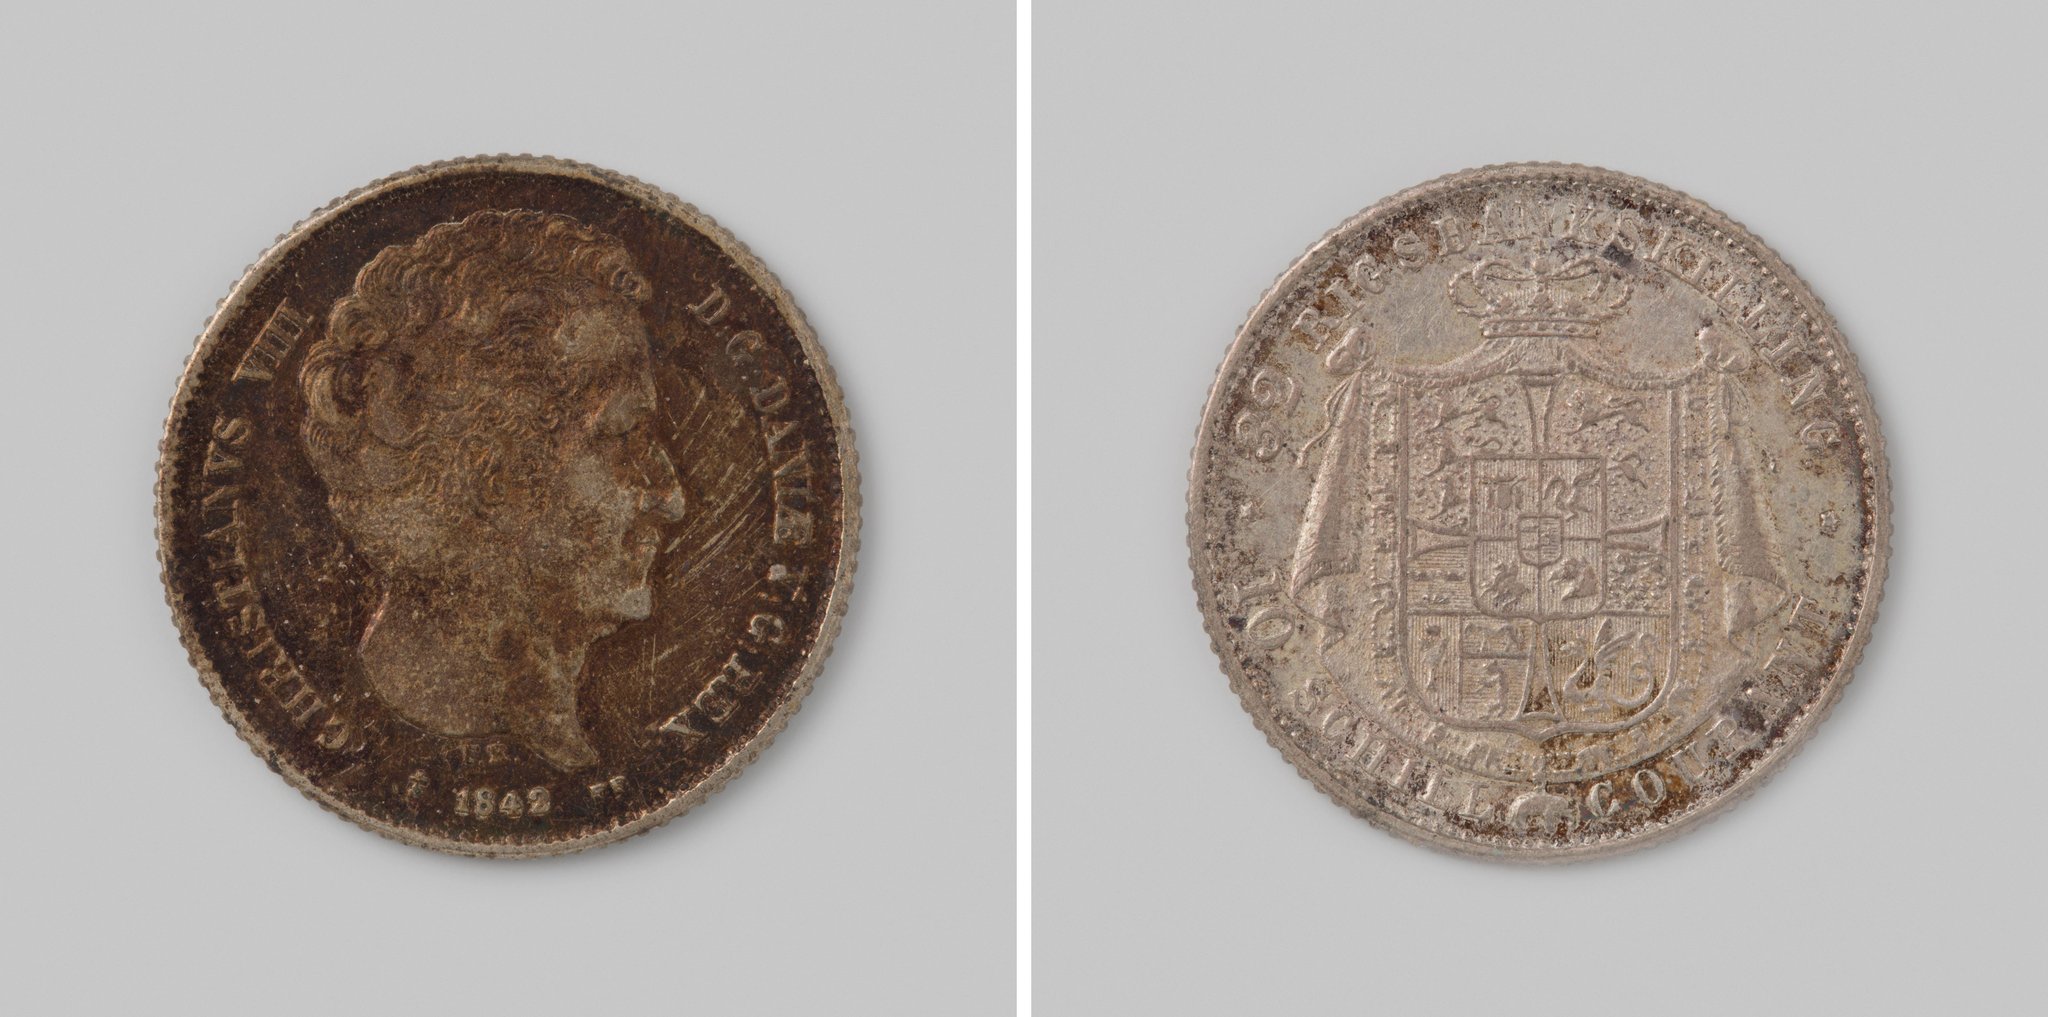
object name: coin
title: 32 rigsbank skilling of 10 schilling courant uit Denemarken van Christiaan VIII, 1842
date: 1842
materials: silver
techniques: striking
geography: altona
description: Zilveren munt. Voorzijde: hoofd van de koning naar rechts. Daaronder jaartal. Keerzijde: op gekroonde mantel door keten van ridderorde met juweel omhangen samengesteld wapenschild. Beide waarde-aanduidingen als omschrift. Kartelrand.